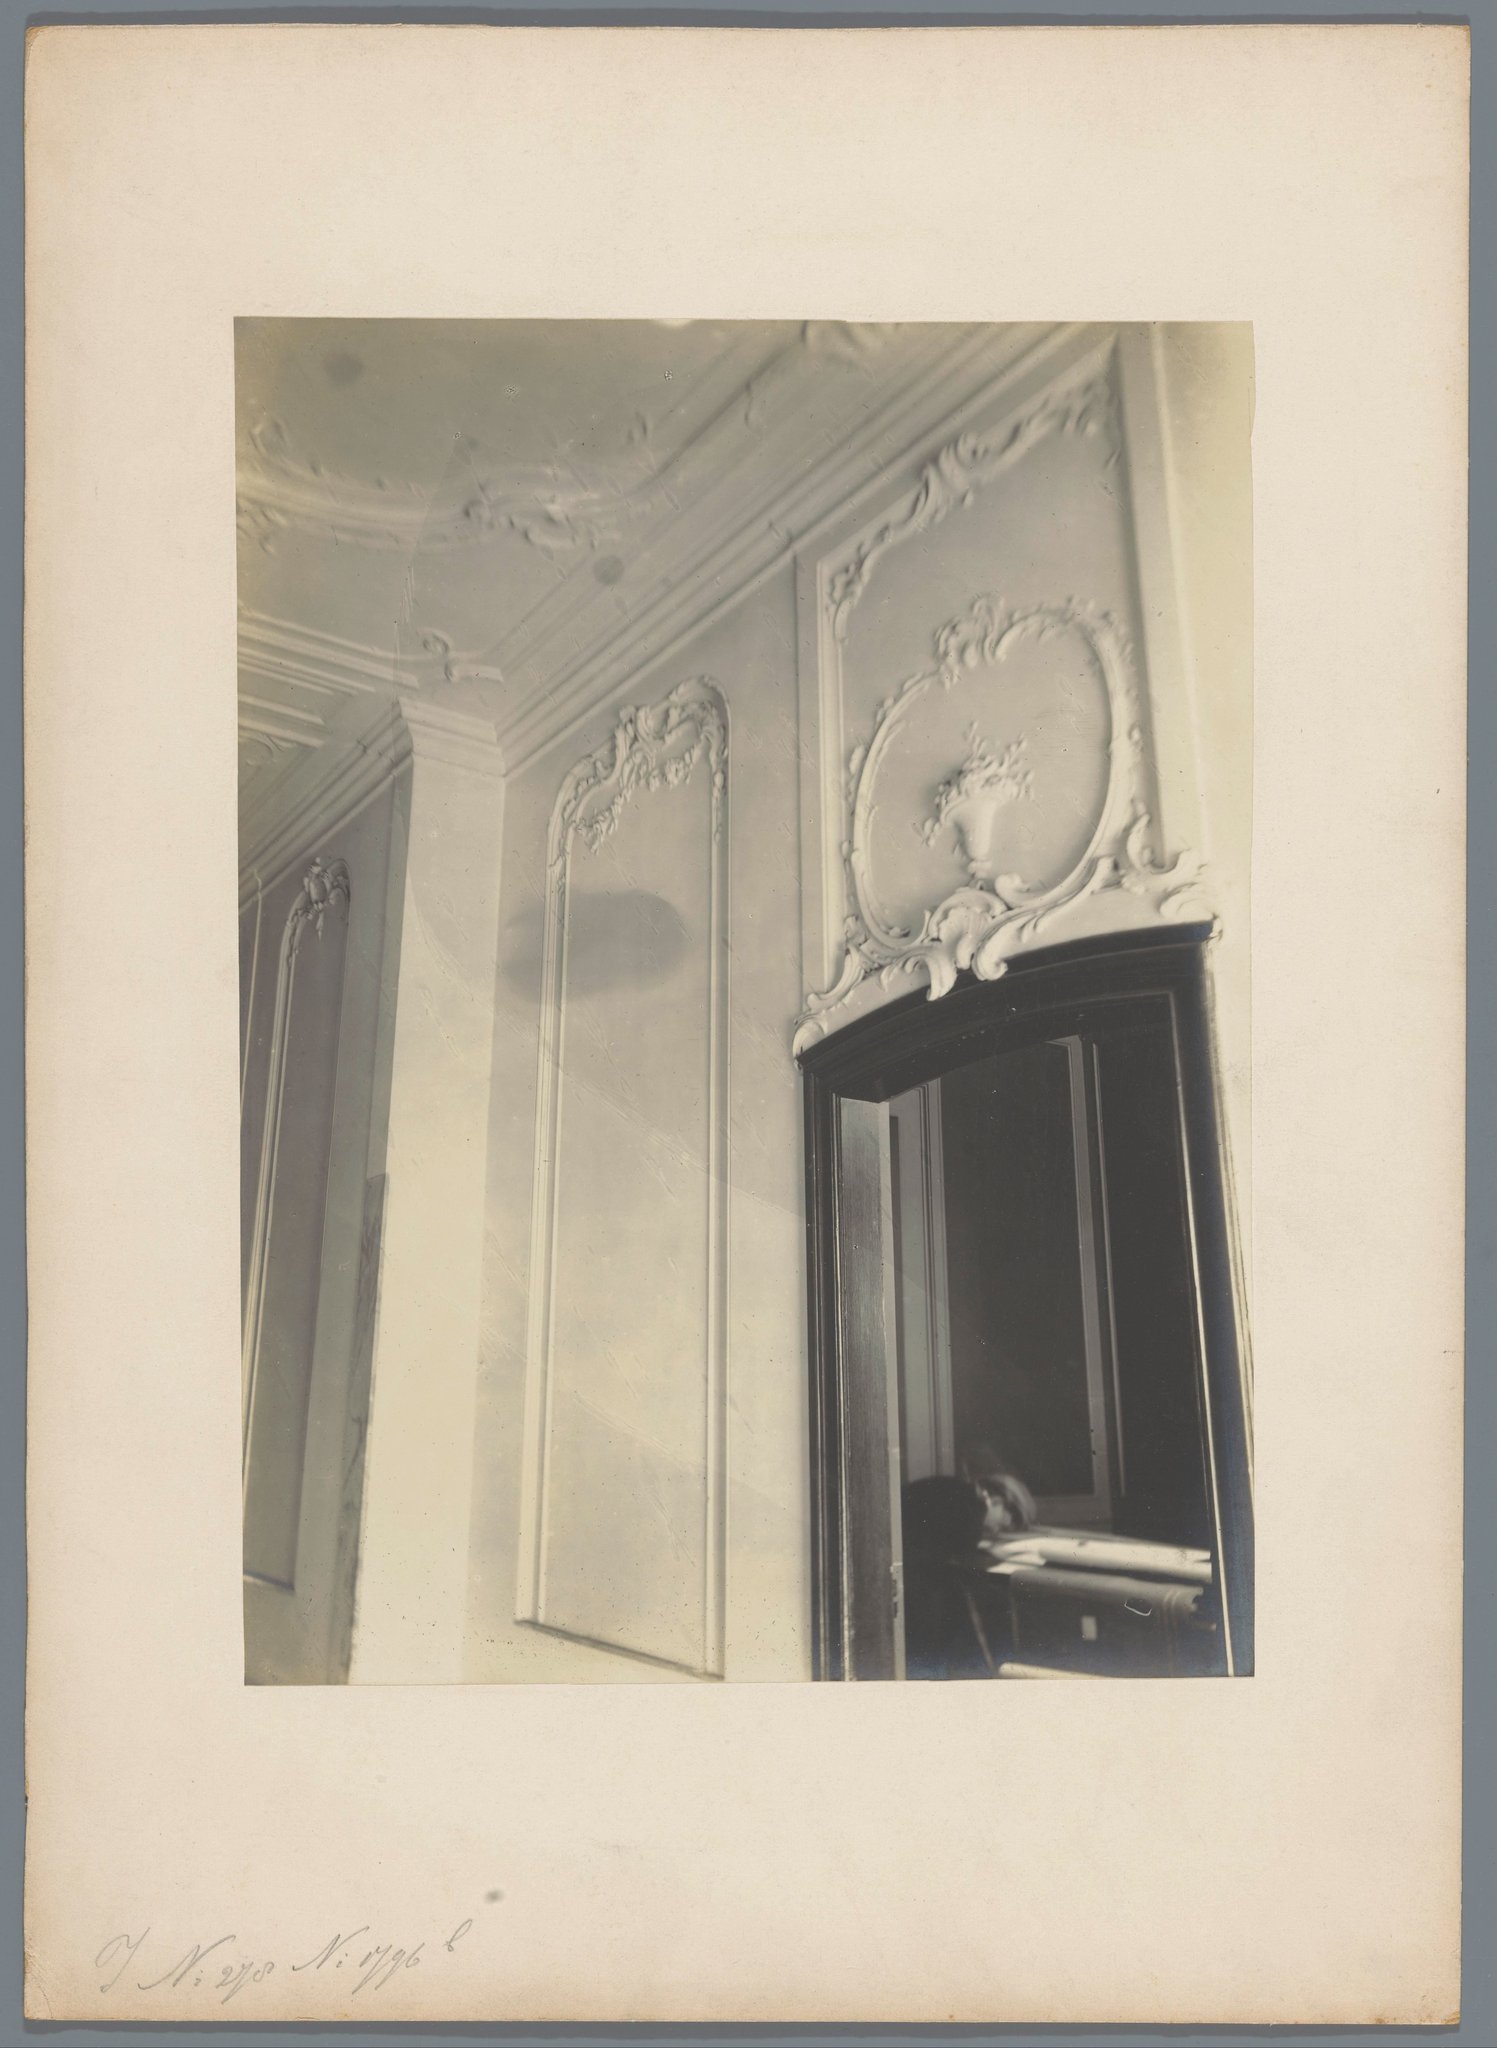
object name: photograph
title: Deel van een hal in het huis aan de Grote Houtstraat 39 te Haarlem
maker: Anonymous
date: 1900-1910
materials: cardboard, photographic support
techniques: gelatin silver print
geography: grote houtstraat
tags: corridor, open door, interior of the house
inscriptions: inscription: ‘neg. no 15254 foto 7483’, annotation, inscription: ‘Haarlem, N. H. Huis Groote Houtstr. 39 verbouwd Juli 1907.’